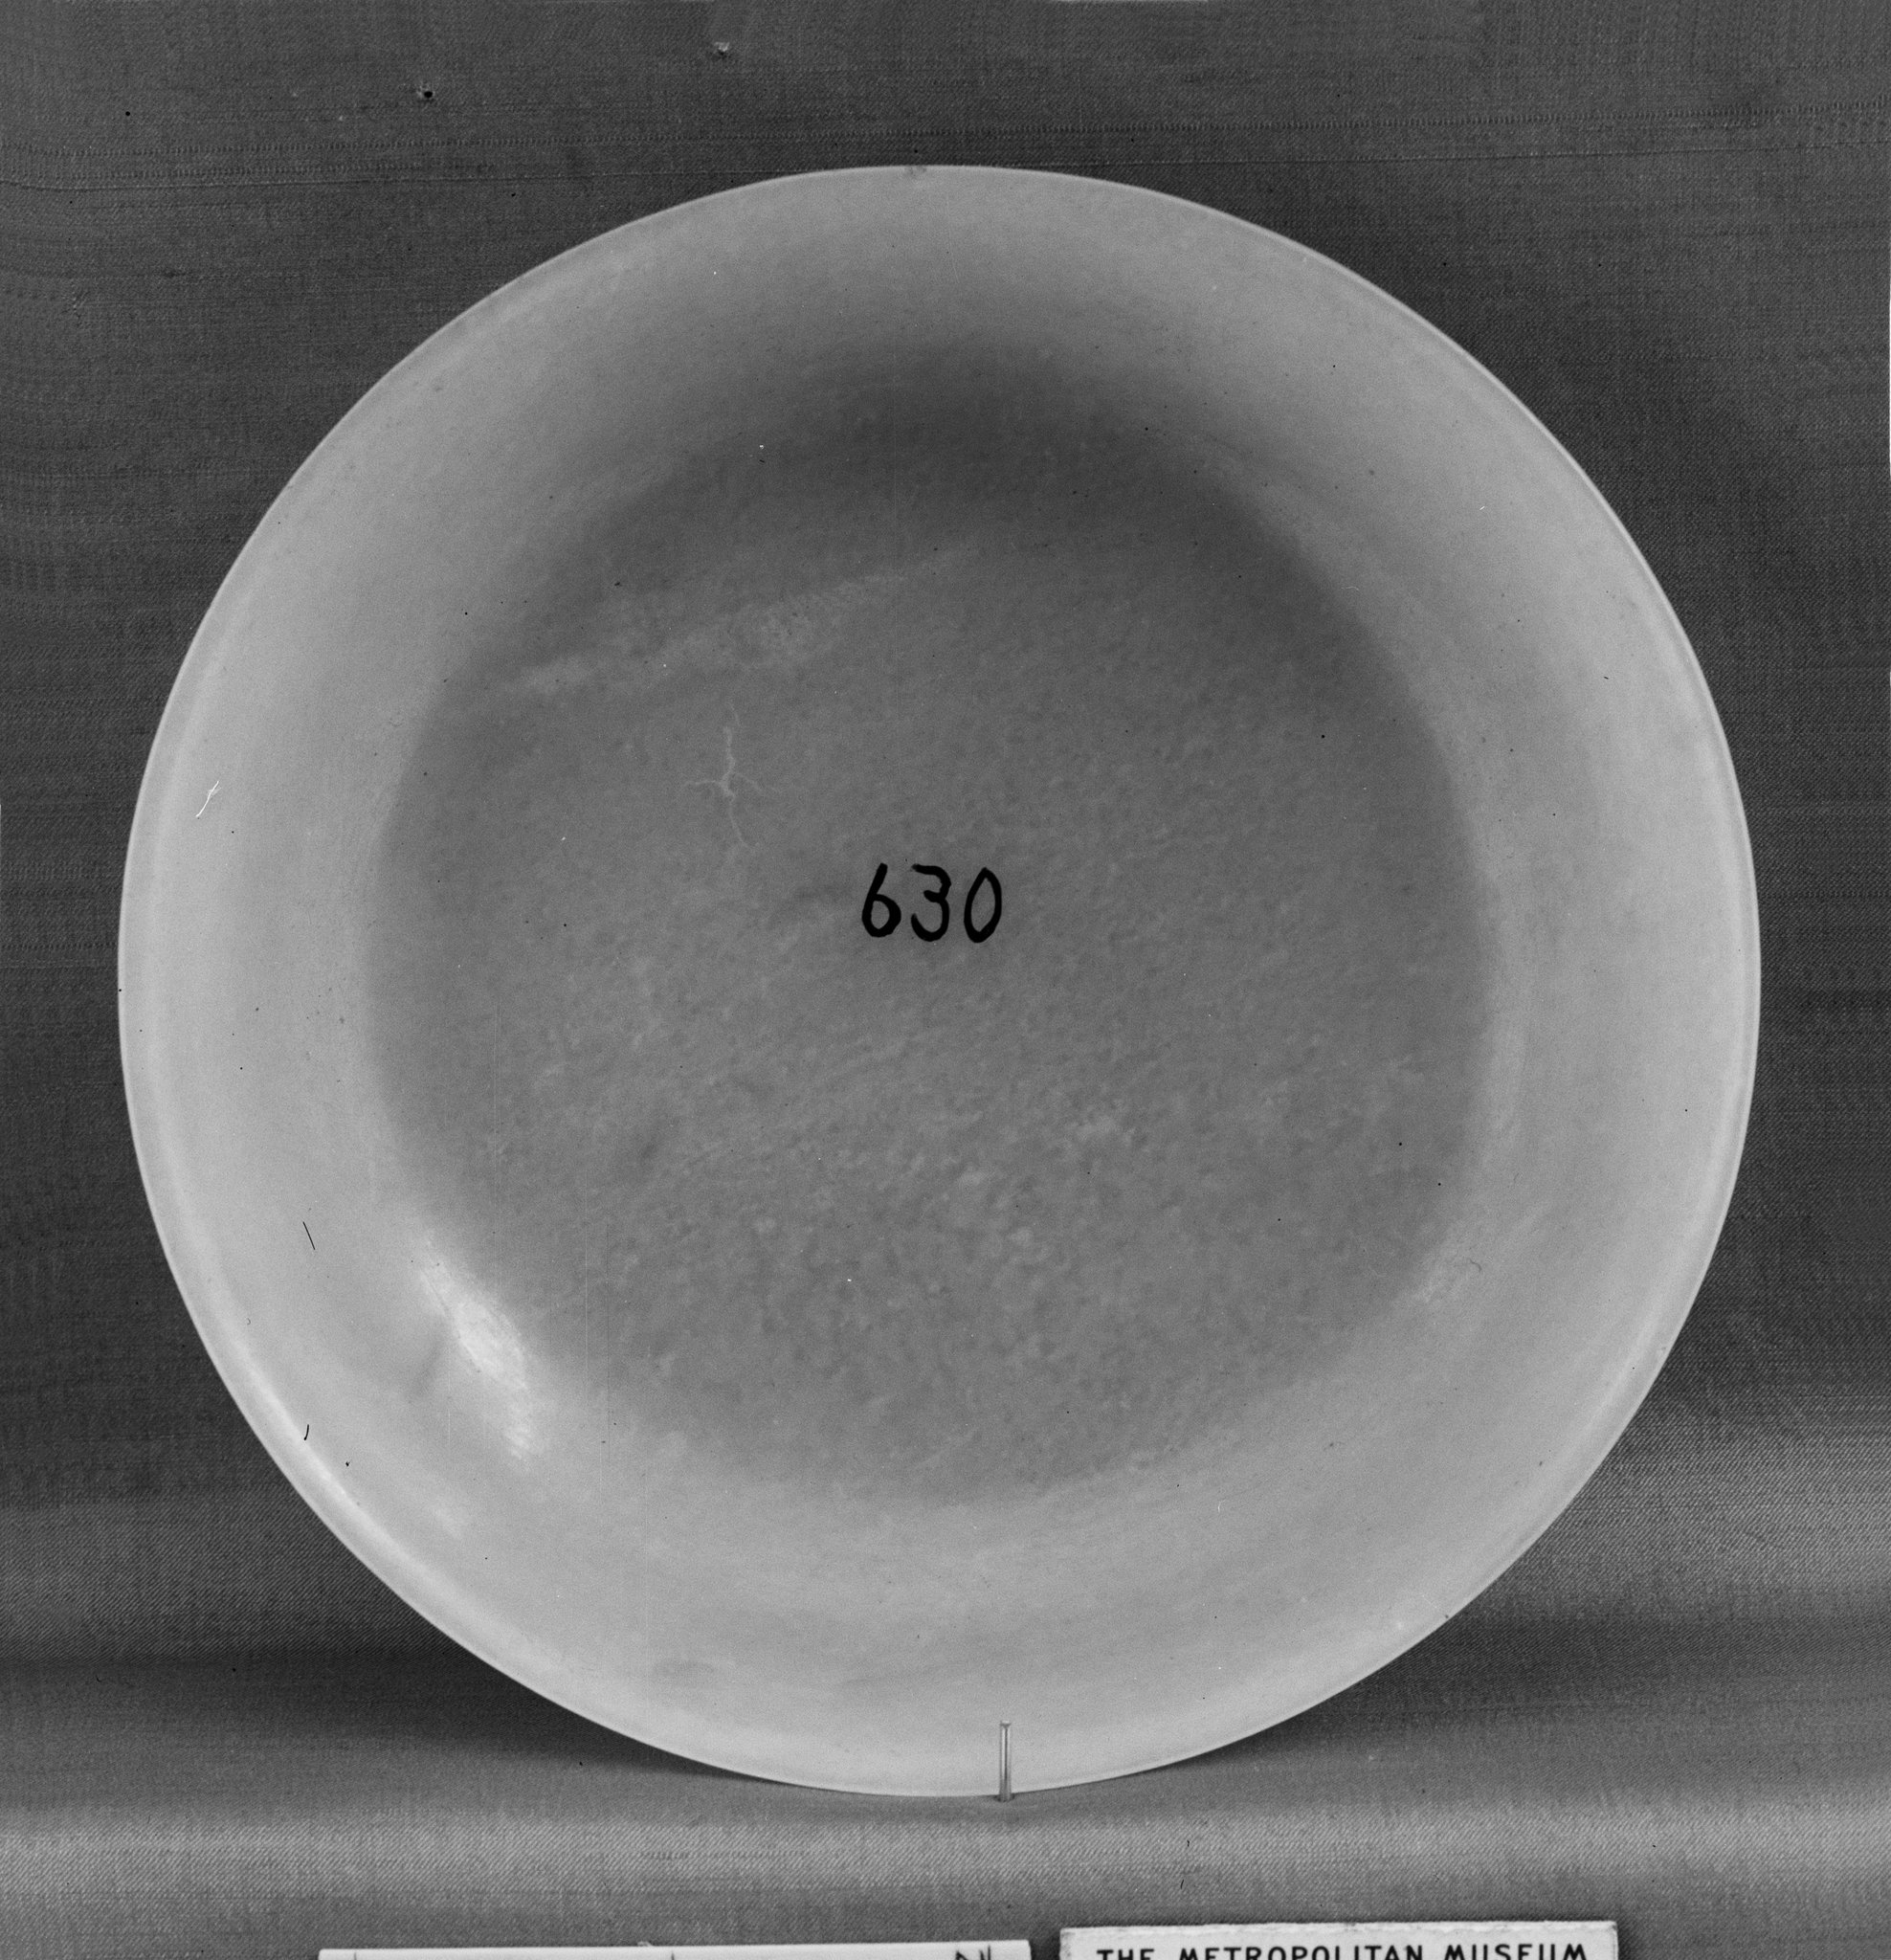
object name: dish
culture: chinese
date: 1736-1795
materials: jade